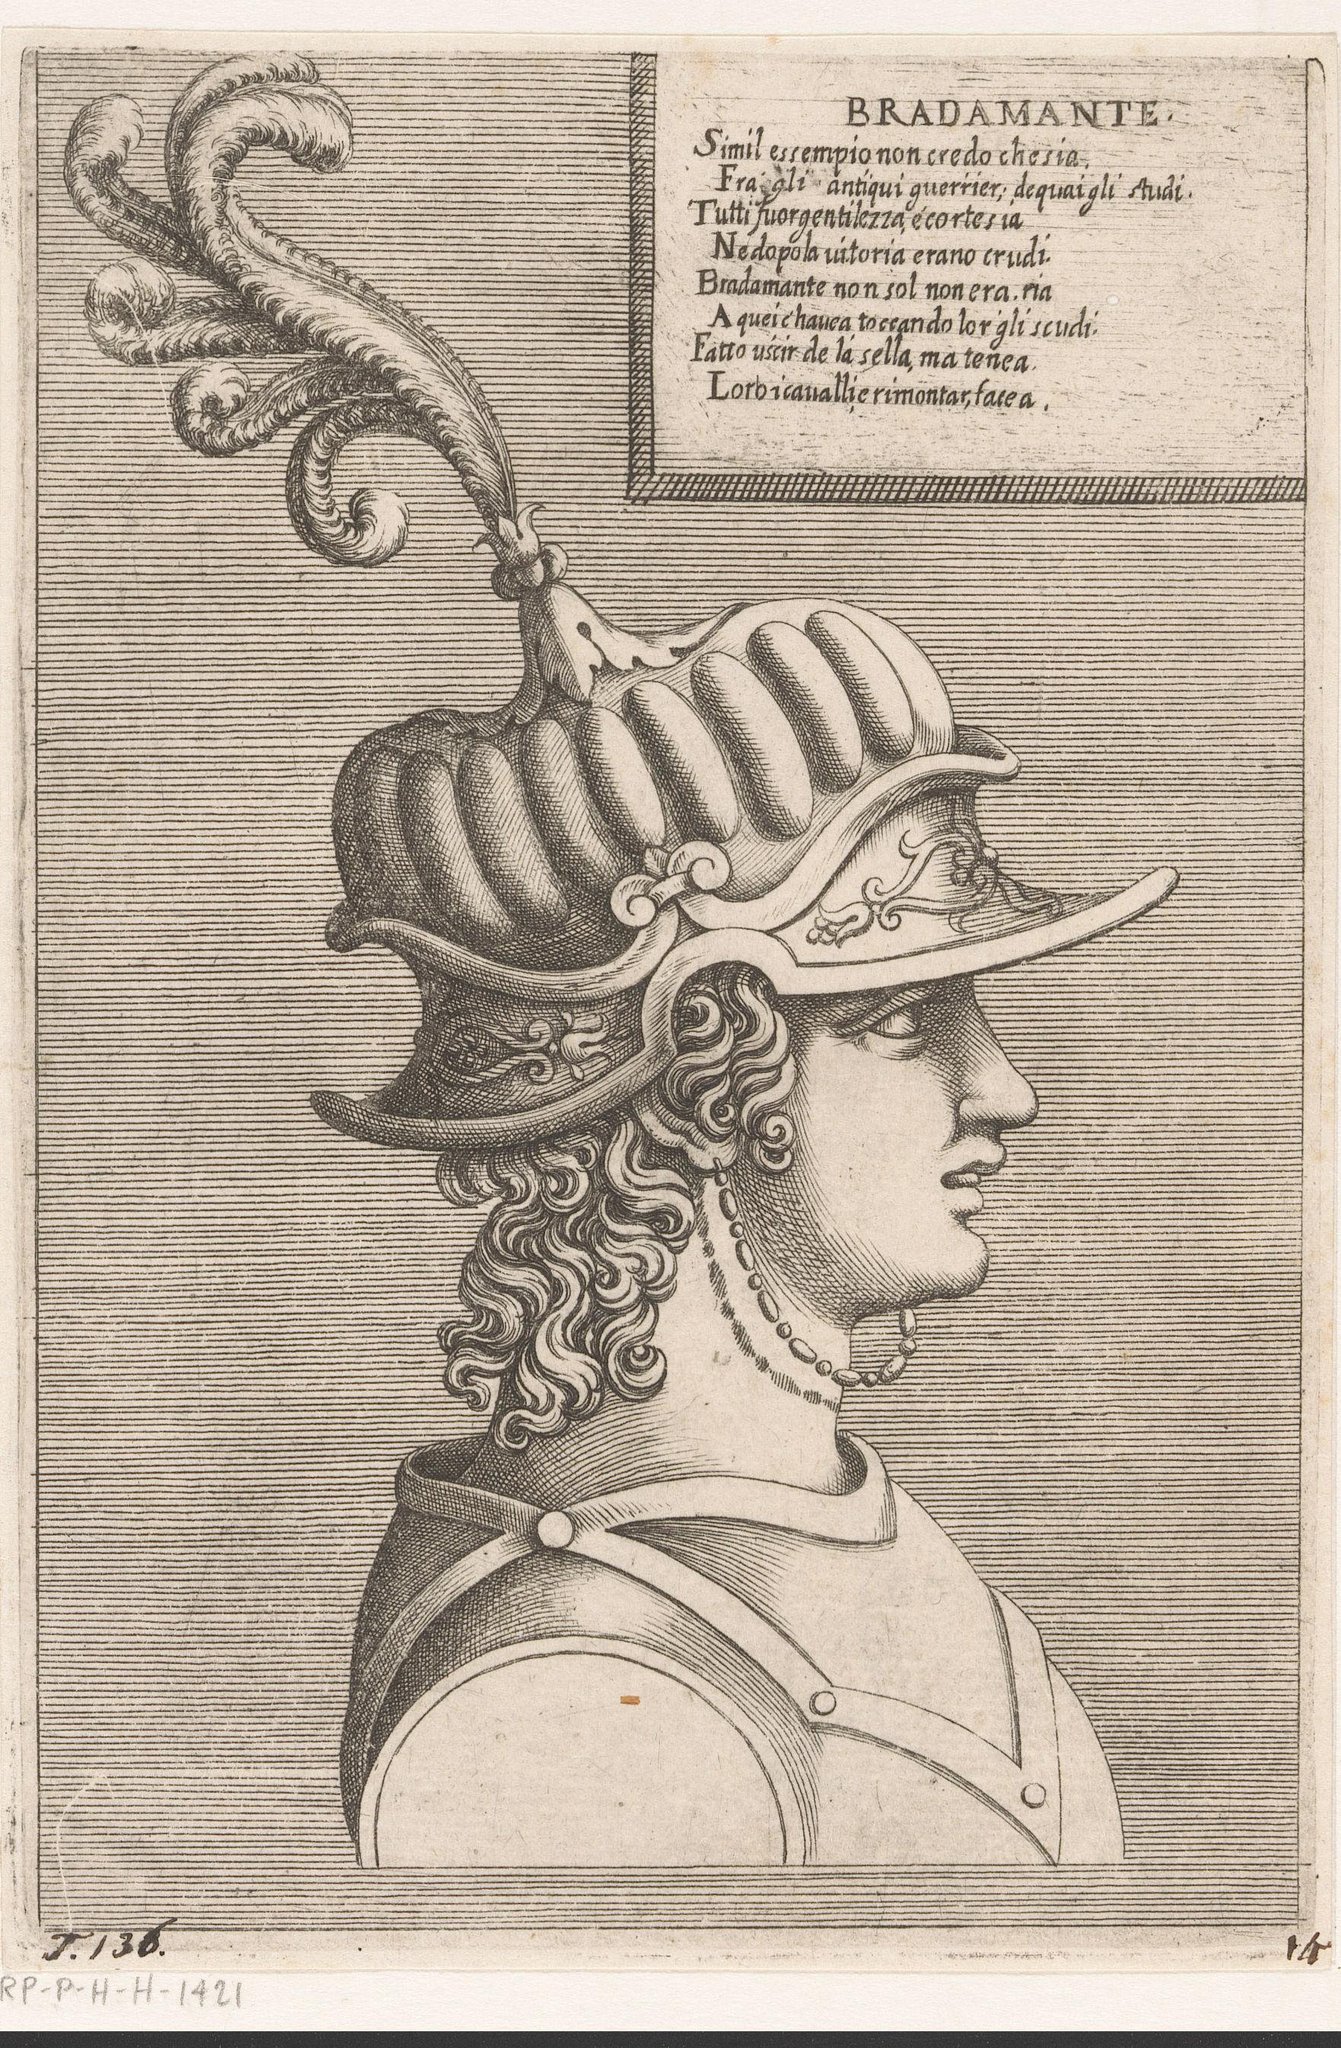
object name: print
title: Buste van Bradamante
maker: Anonymous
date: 1550-1599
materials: paper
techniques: engraving, etching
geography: italy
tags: helmet, male characters from 'orlando furioso' : use 82a(...)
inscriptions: collector's mark: Lugt 2228, collector's mark: Lugt 11, inscription: ‘T. 136.’, number: ‘14’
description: Buste van Bradamante, een karakter uit Ludovico Ariosto's epos 'Orlando Furioso'. Op haar hoofd draagt zij een helm gedecoreerd met een pluim van veren. Rechtsboven de titel en acht Italiaanse versregels uit het epos.